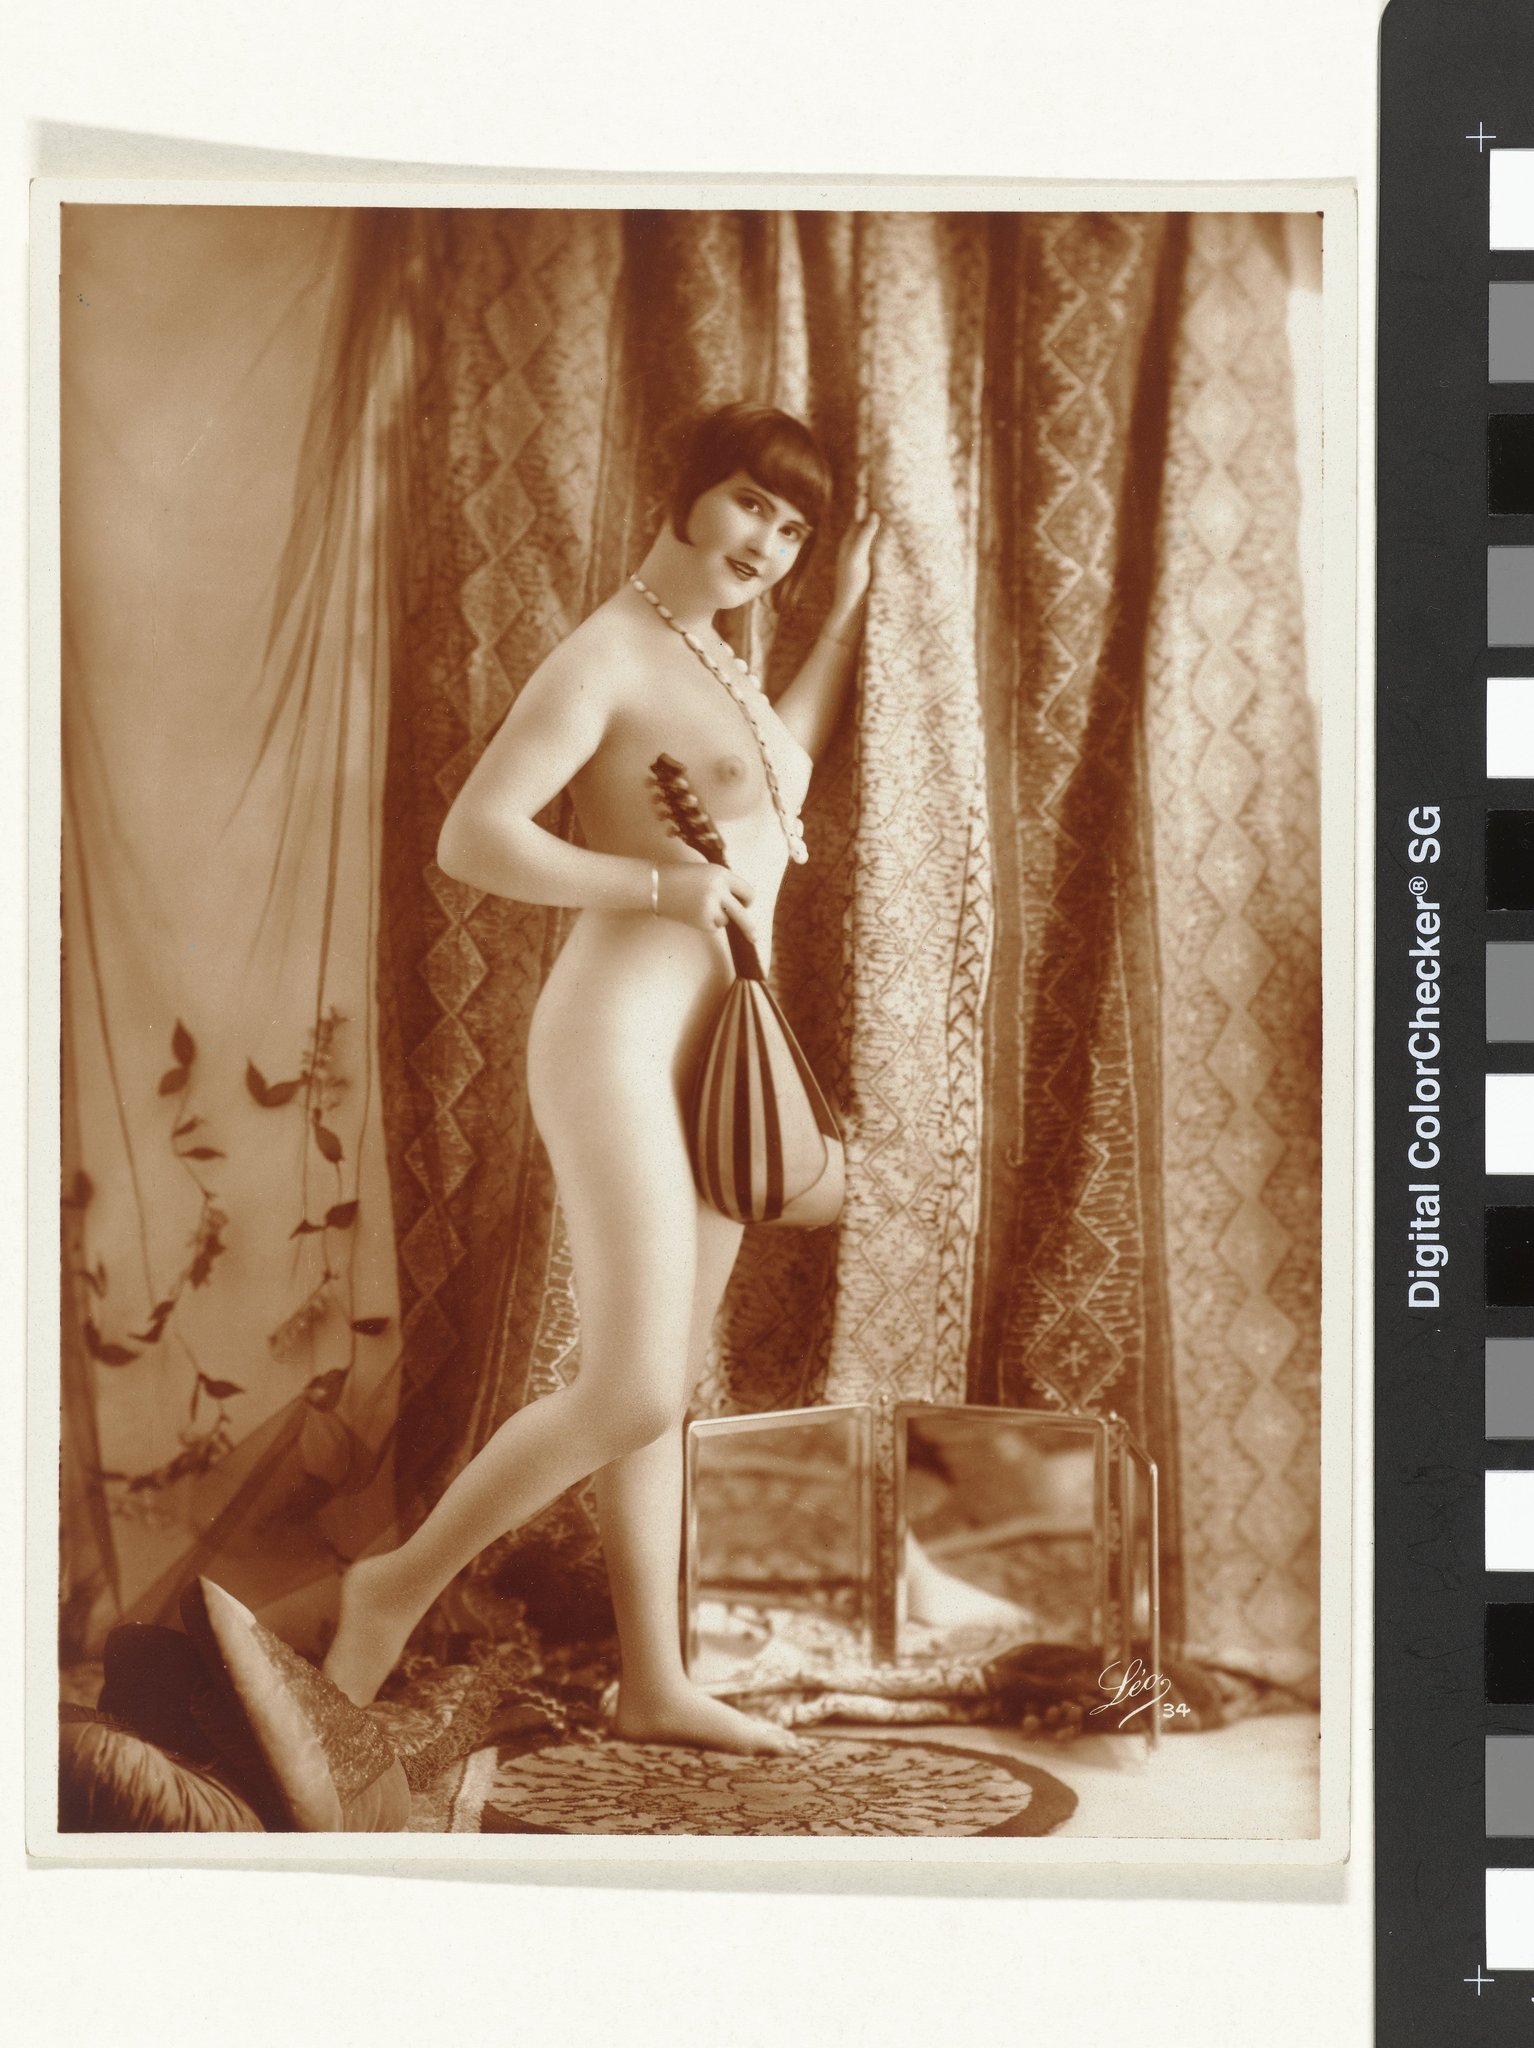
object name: photograph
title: Standing Female Nude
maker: léo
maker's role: fotograaf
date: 1900-1920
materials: paper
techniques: gelatin silver print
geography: france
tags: the (nude) human figure; 'corpo humano' (ripa) - aa - female human figure, cithern, mandolin, guitar, balalaika, france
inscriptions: number: ‘34’